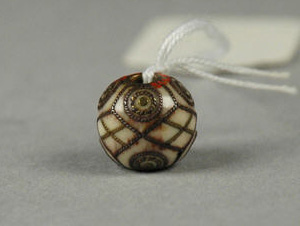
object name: ojime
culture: japanese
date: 1801-1900